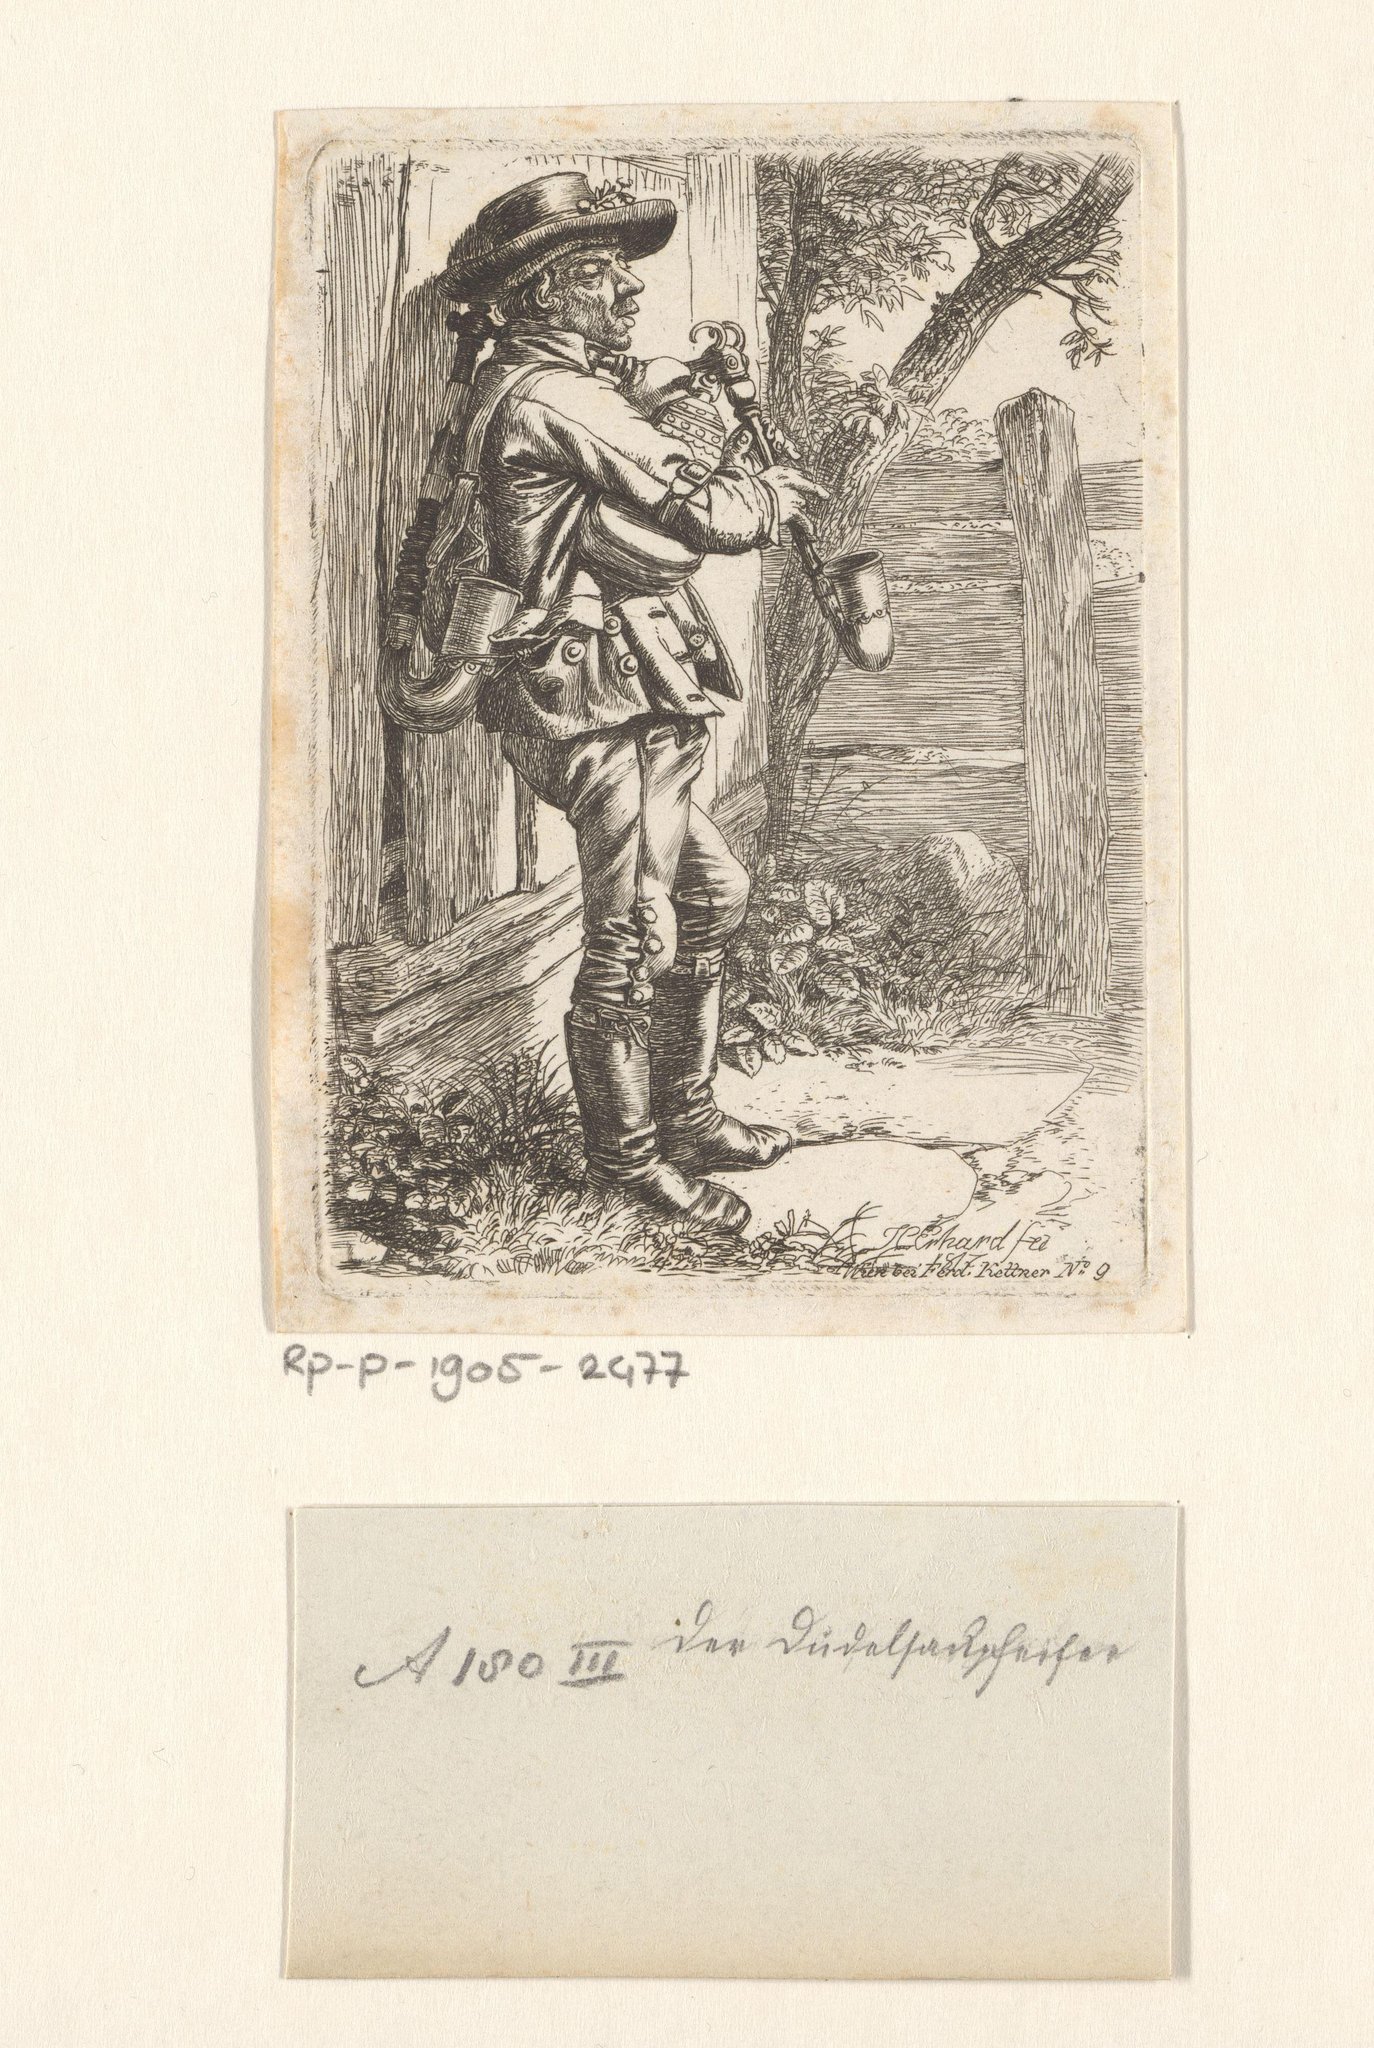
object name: print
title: Doedelzakspeler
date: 1817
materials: paper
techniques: etching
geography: vienna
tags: one person playing wind instrument, bagpipe, musette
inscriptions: collector's mark: Lugt 2228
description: Naast het adres van de uitgever staat 'No. 9' vermeld.